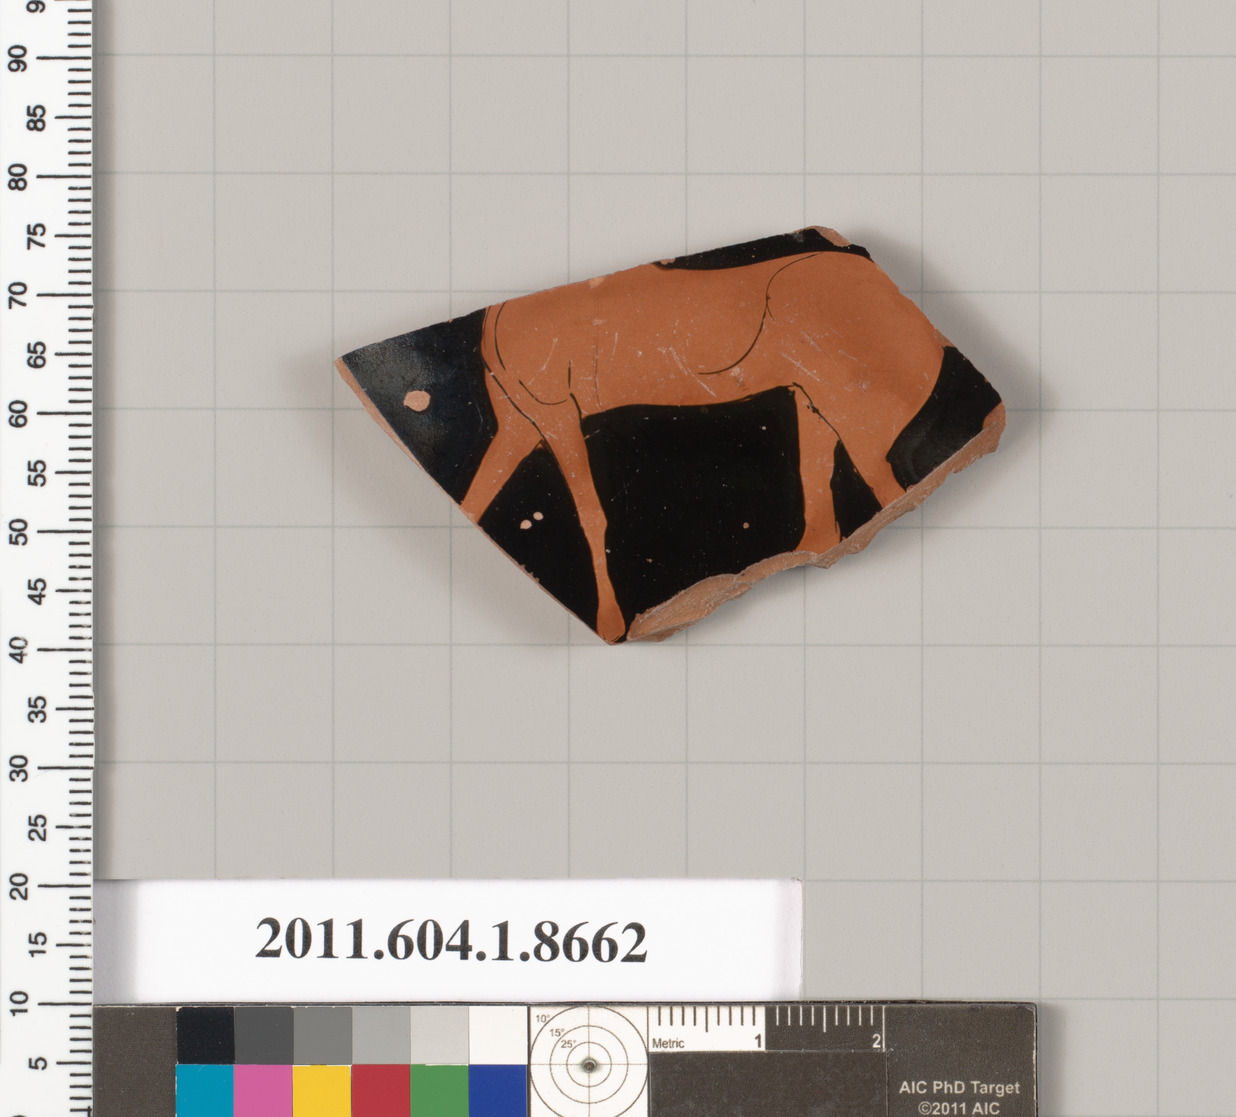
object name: kylix fragment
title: Terracotta rim fragment of a stemless? kylix (drinking cup)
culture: greek, attic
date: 475-451 BCE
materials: terracotta